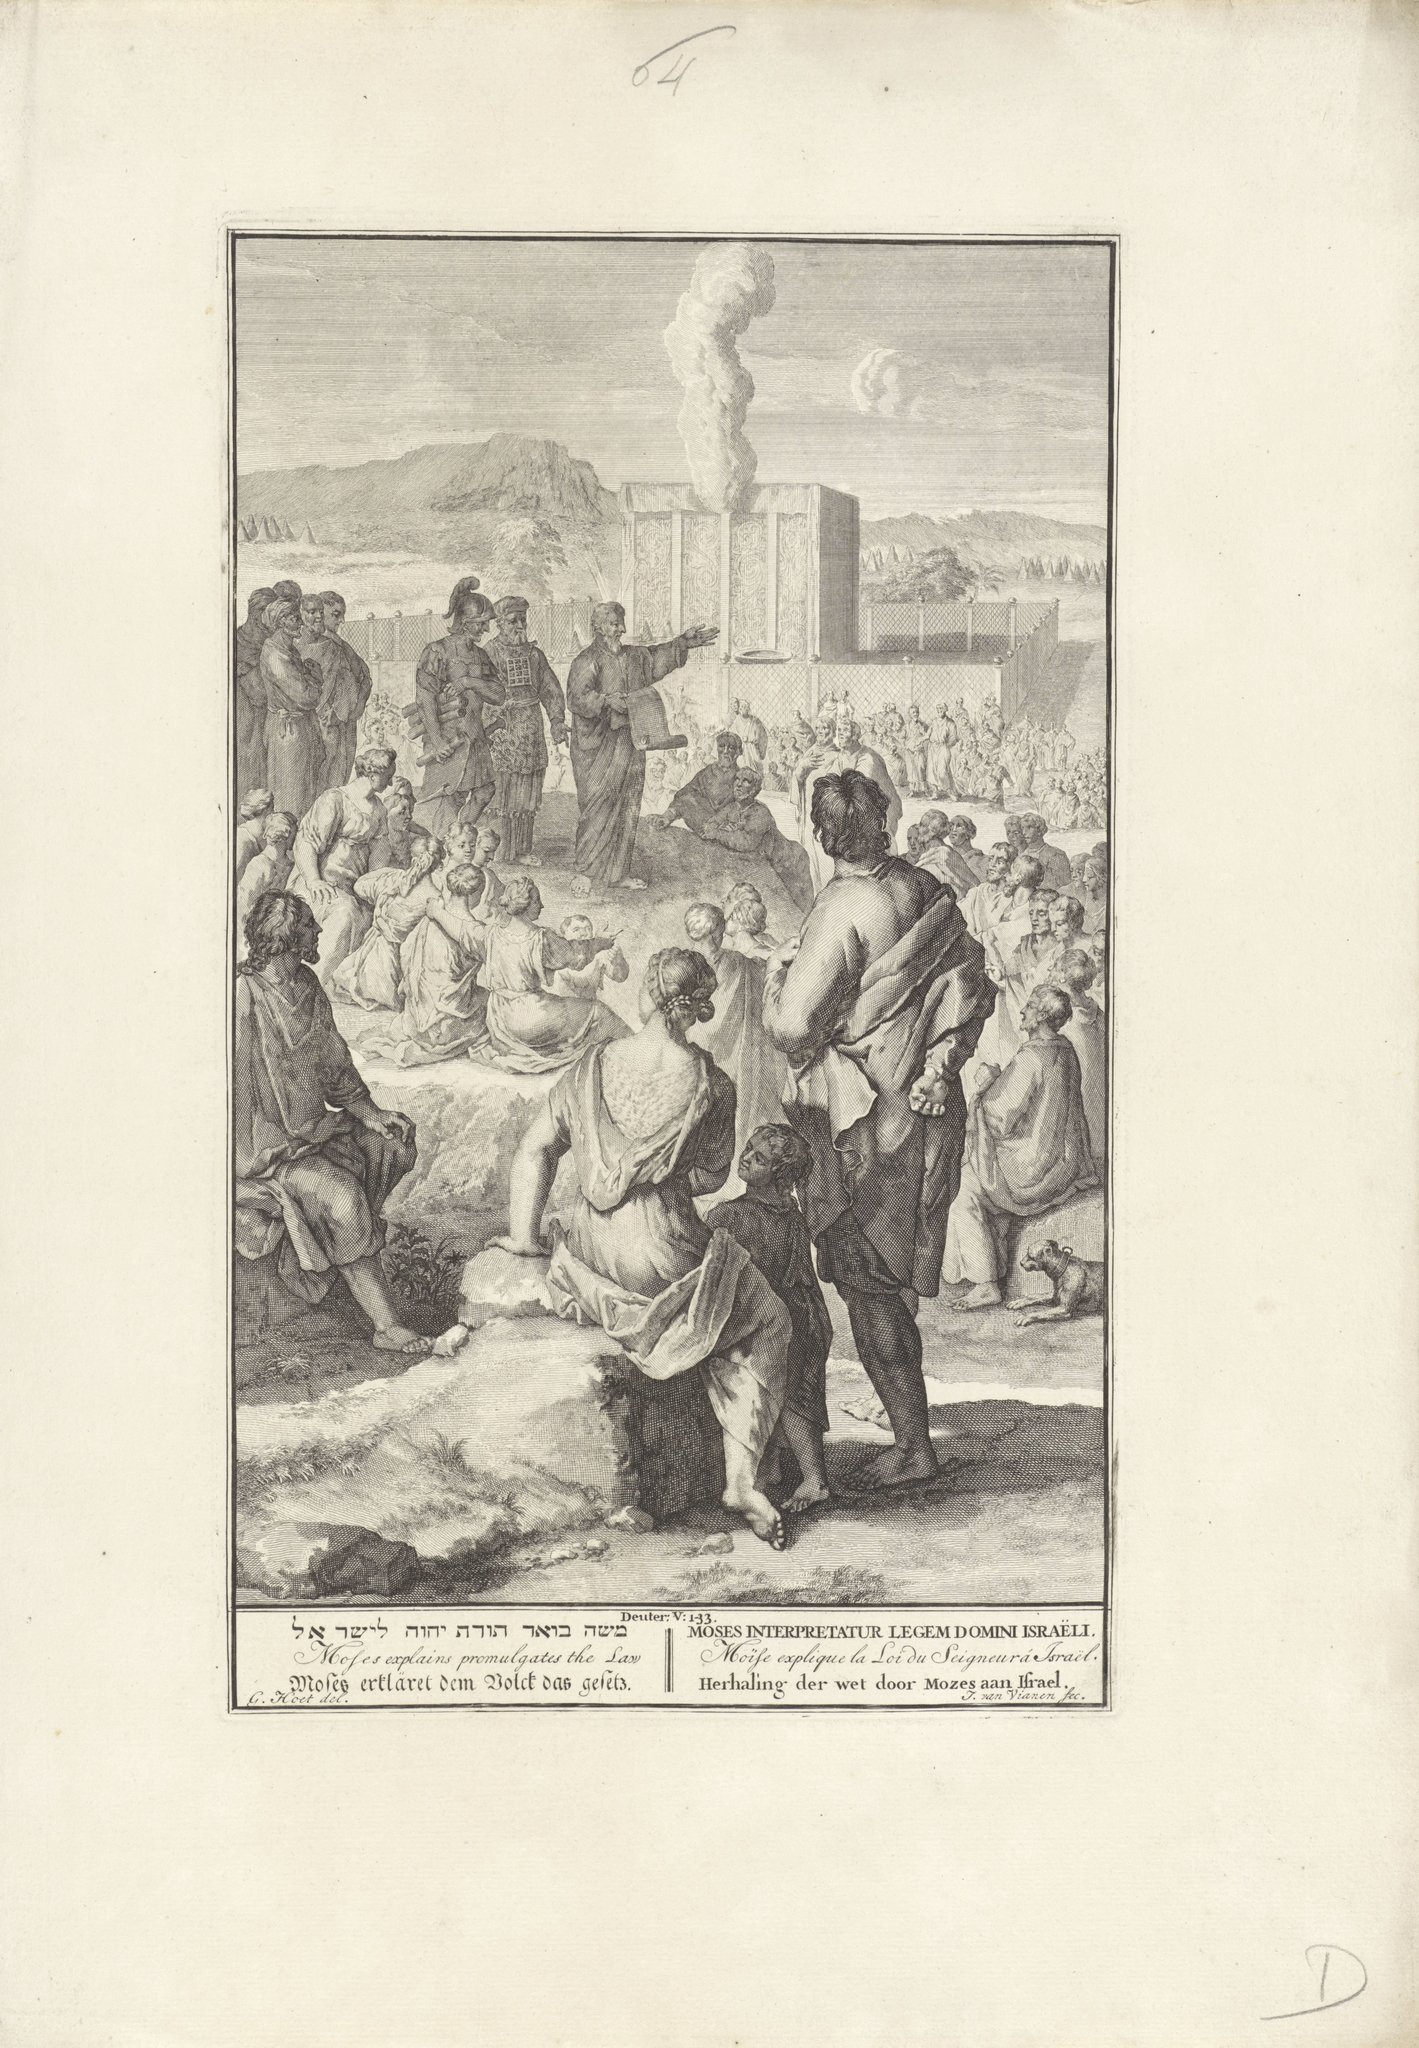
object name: book illustration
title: Mozes onderwijst Israëlieten in wetten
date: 1705-1720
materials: paper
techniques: engraving, etching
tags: moses teaching (in general)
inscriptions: collector's mark: Lugt 2228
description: Prent oorspronkelijk bedoeld voor: Figures de la Bible. Amsterdam: Bernard Picart, 1720. Prent ook gebruikt in: Taferelen der voornaamste geschiedenissen van het Oude en Nieuwe Testament (...) door de vermaarde kunstenaars Hoet, Houbraken, en Picart getekent (...) en met beschrijvingen uitgebreid. Den Haag: Pieter de Hondt, 1728.